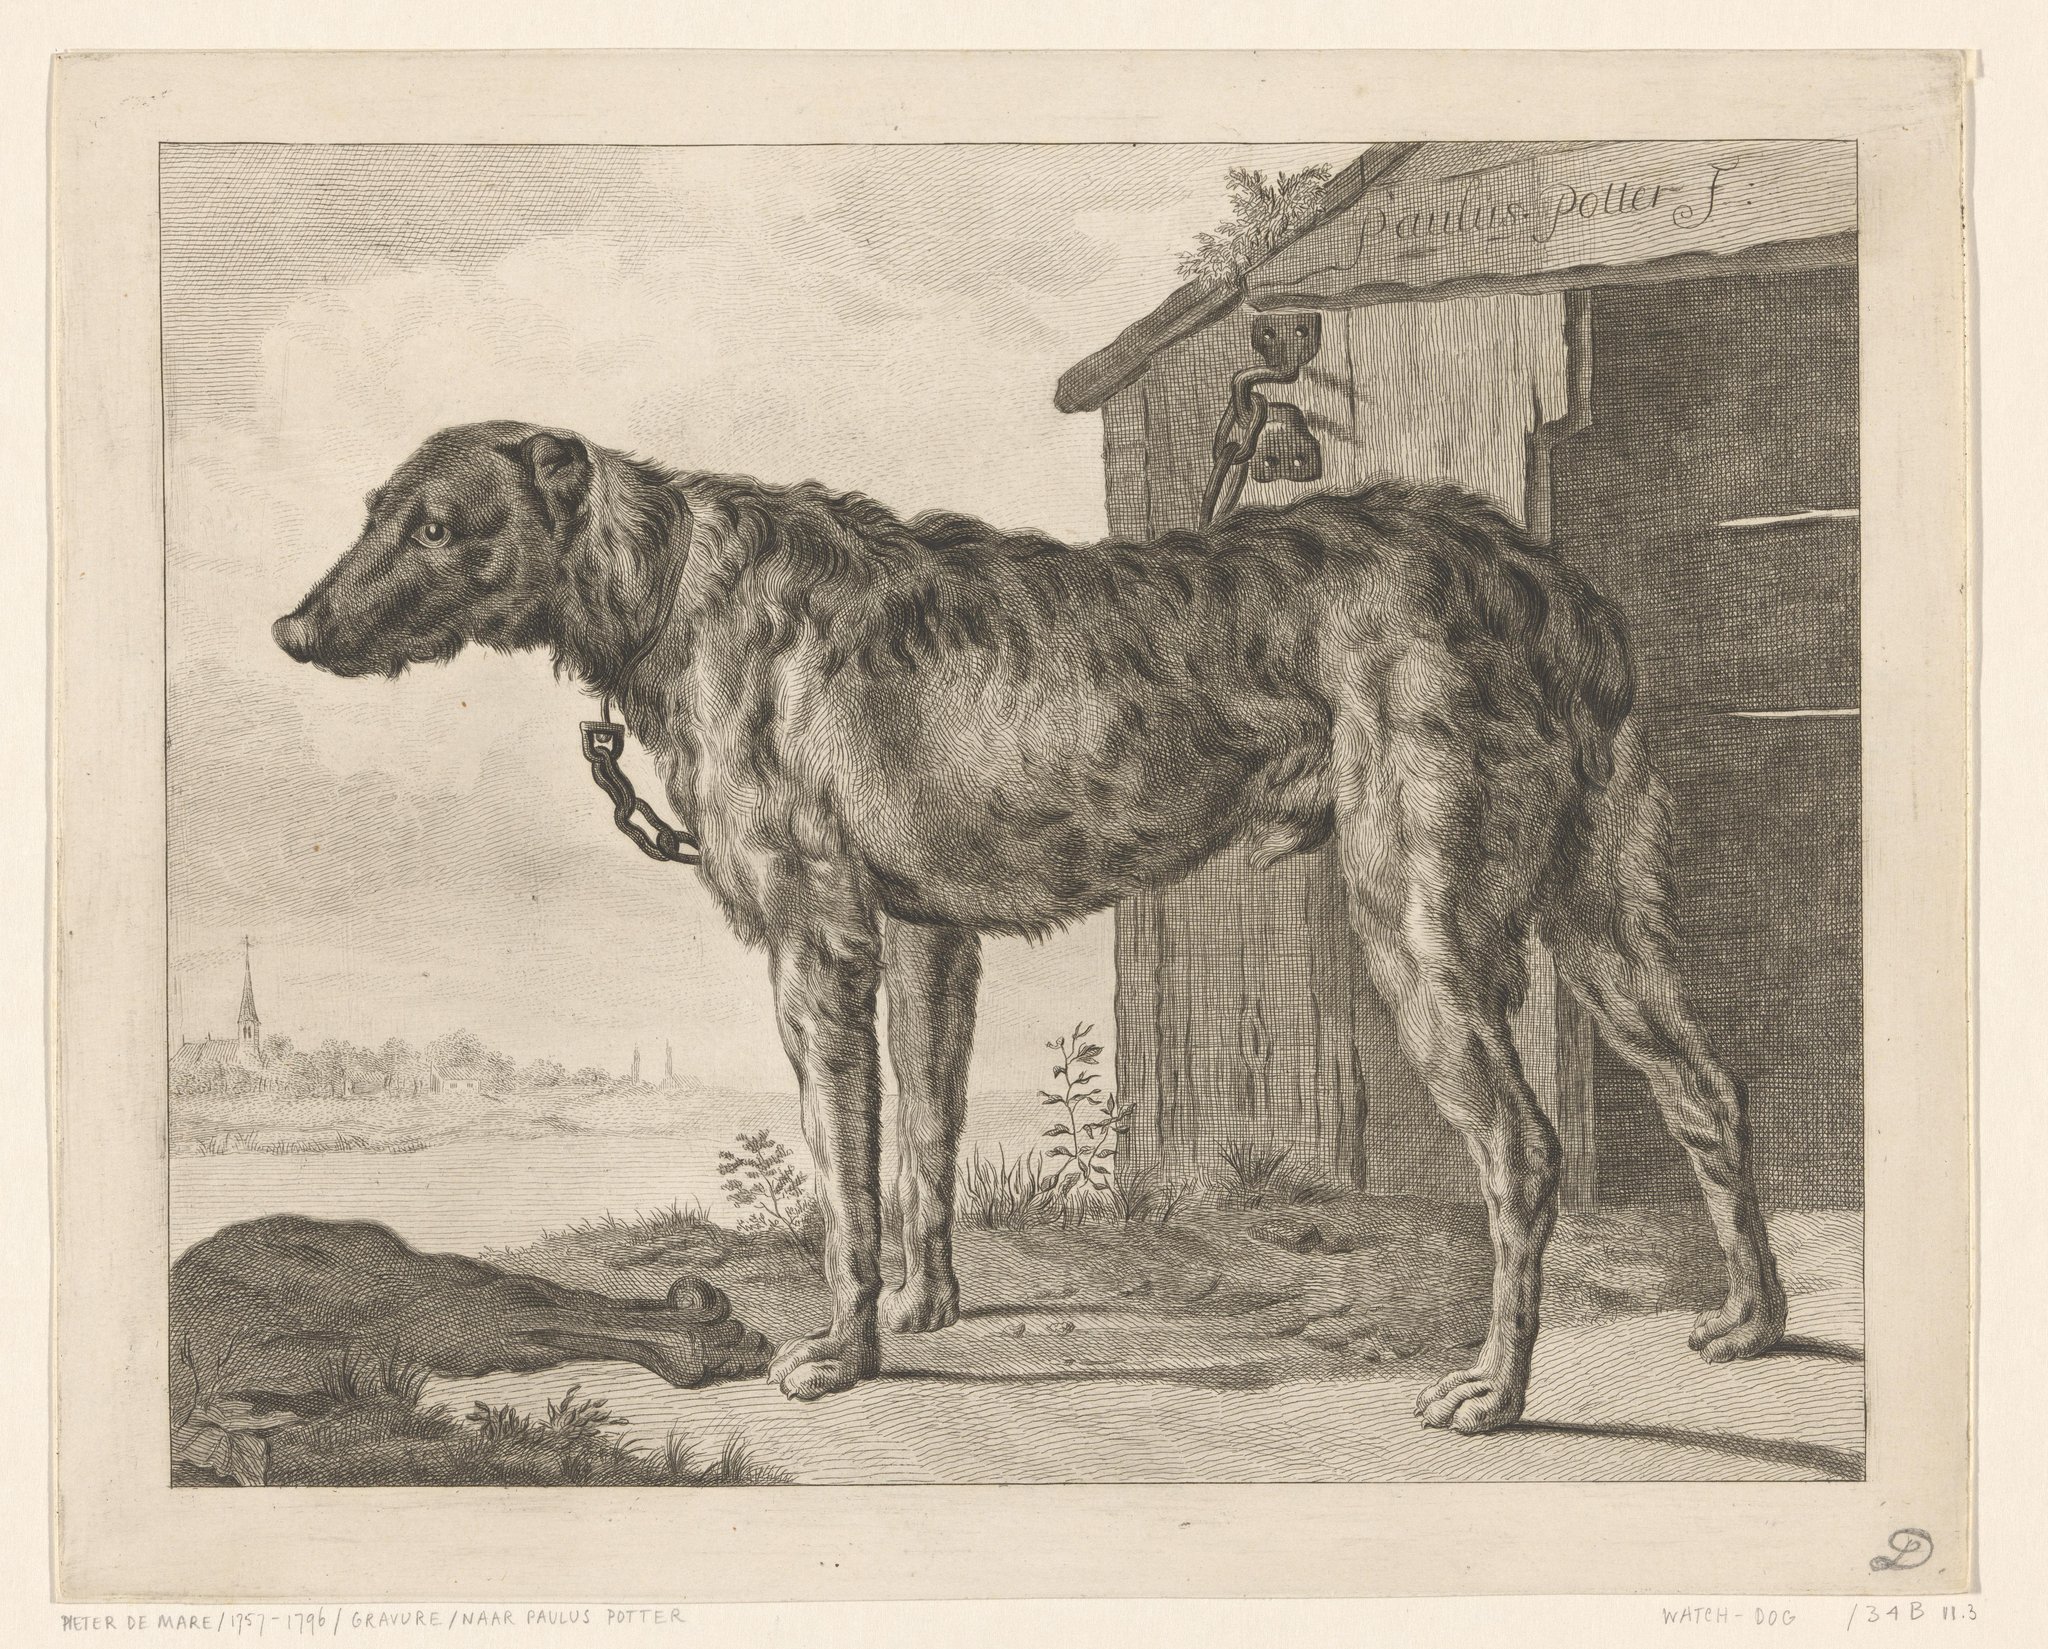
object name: print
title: Hond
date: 1768-1796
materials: paper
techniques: engraving, etching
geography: leiden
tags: dog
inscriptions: collector's mark: Lugt 2228